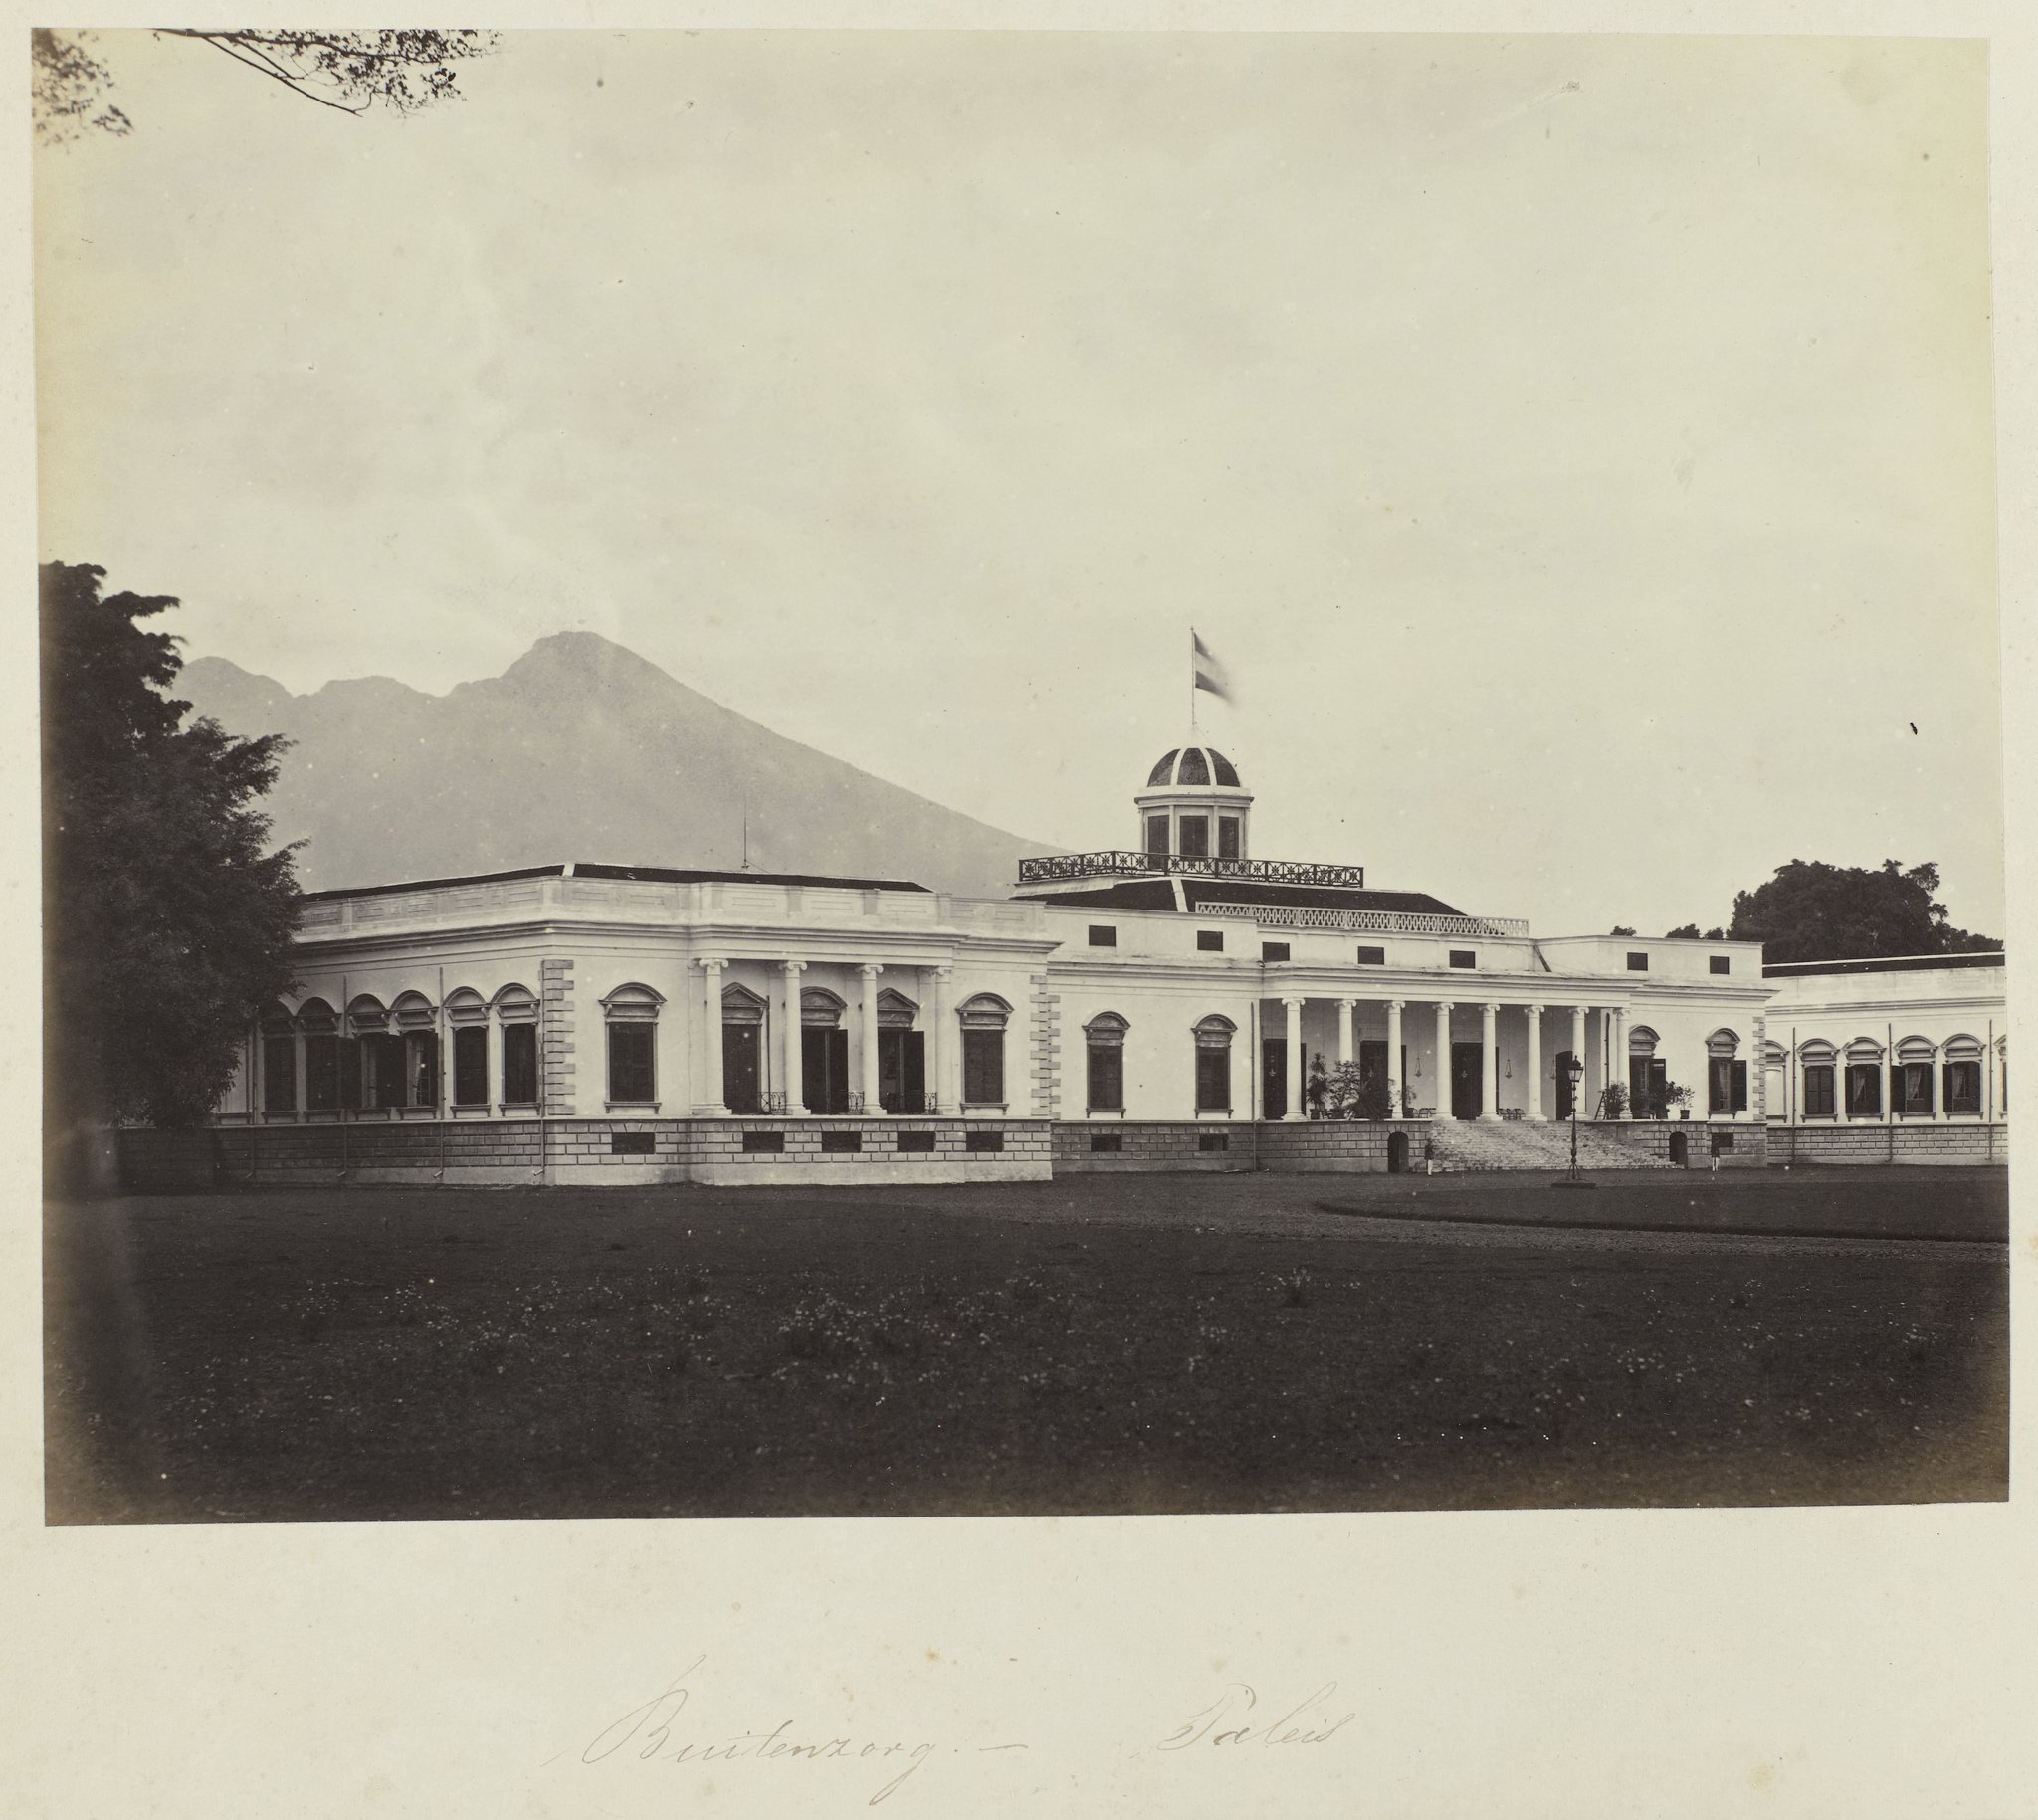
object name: photograph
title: Buitenzorg - Paleis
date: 1863-1869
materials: photographic support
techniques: albumen print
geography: buitenzorg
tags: colonial government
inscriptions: inscription: ‘Buitenzorg. - Paleis’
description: Gezicht op het paleis van de gouverneur-generaal in Buitenzorg. Onderdeel van het groene fotoalbum met foto's van Java, uit het bezit van apotheker Specht-Grijp, die in 1865 vanuit Batavia naar Nederland terugkeerde.